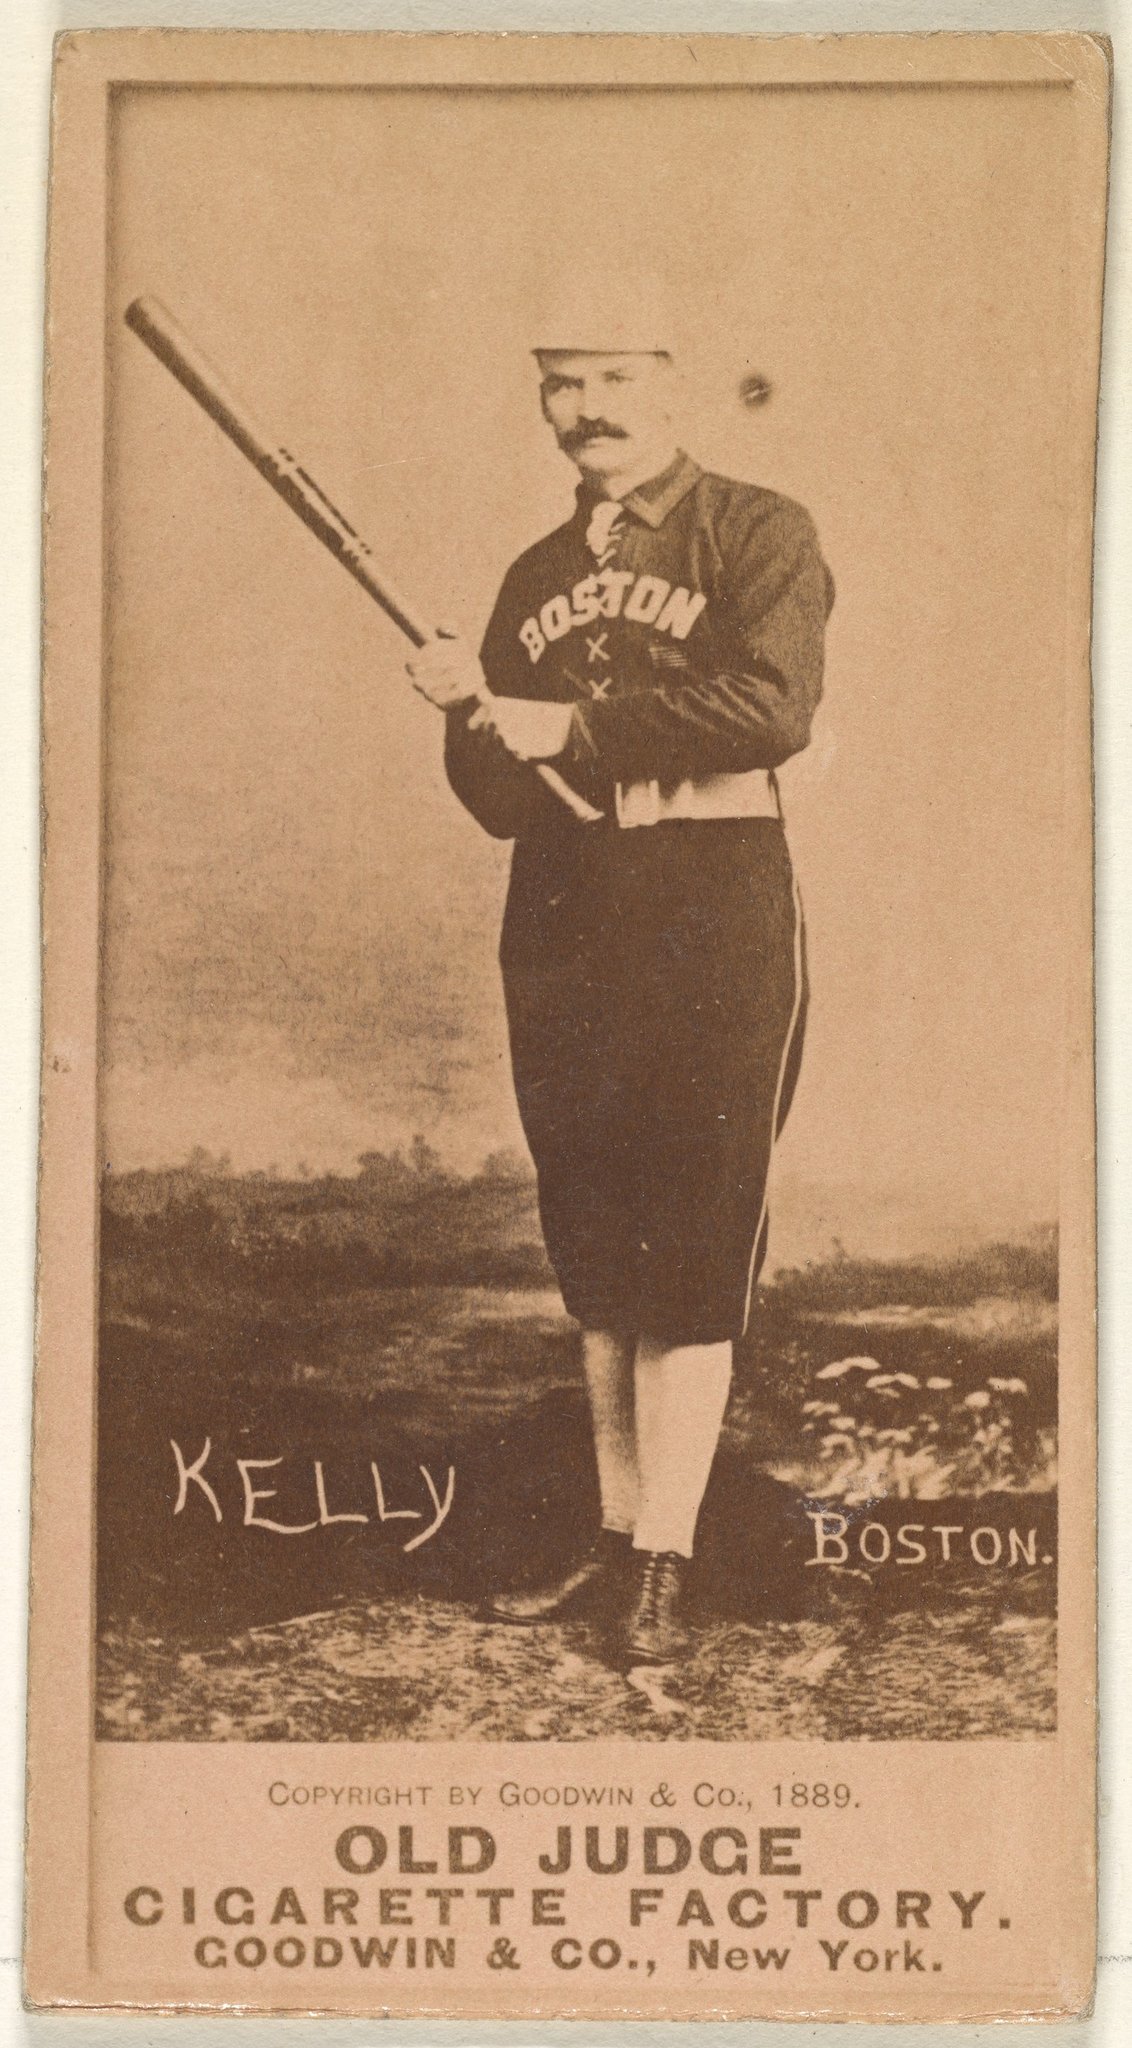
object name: baseball card, photograph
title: Kelly, Boston, from the Old Judge series (N172) for Old Judge Cigarettes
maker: goodwin & company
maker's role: publisher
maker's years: 1850-1950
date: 1889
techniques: albumen silver print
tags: men,portraits,baseball,athletes